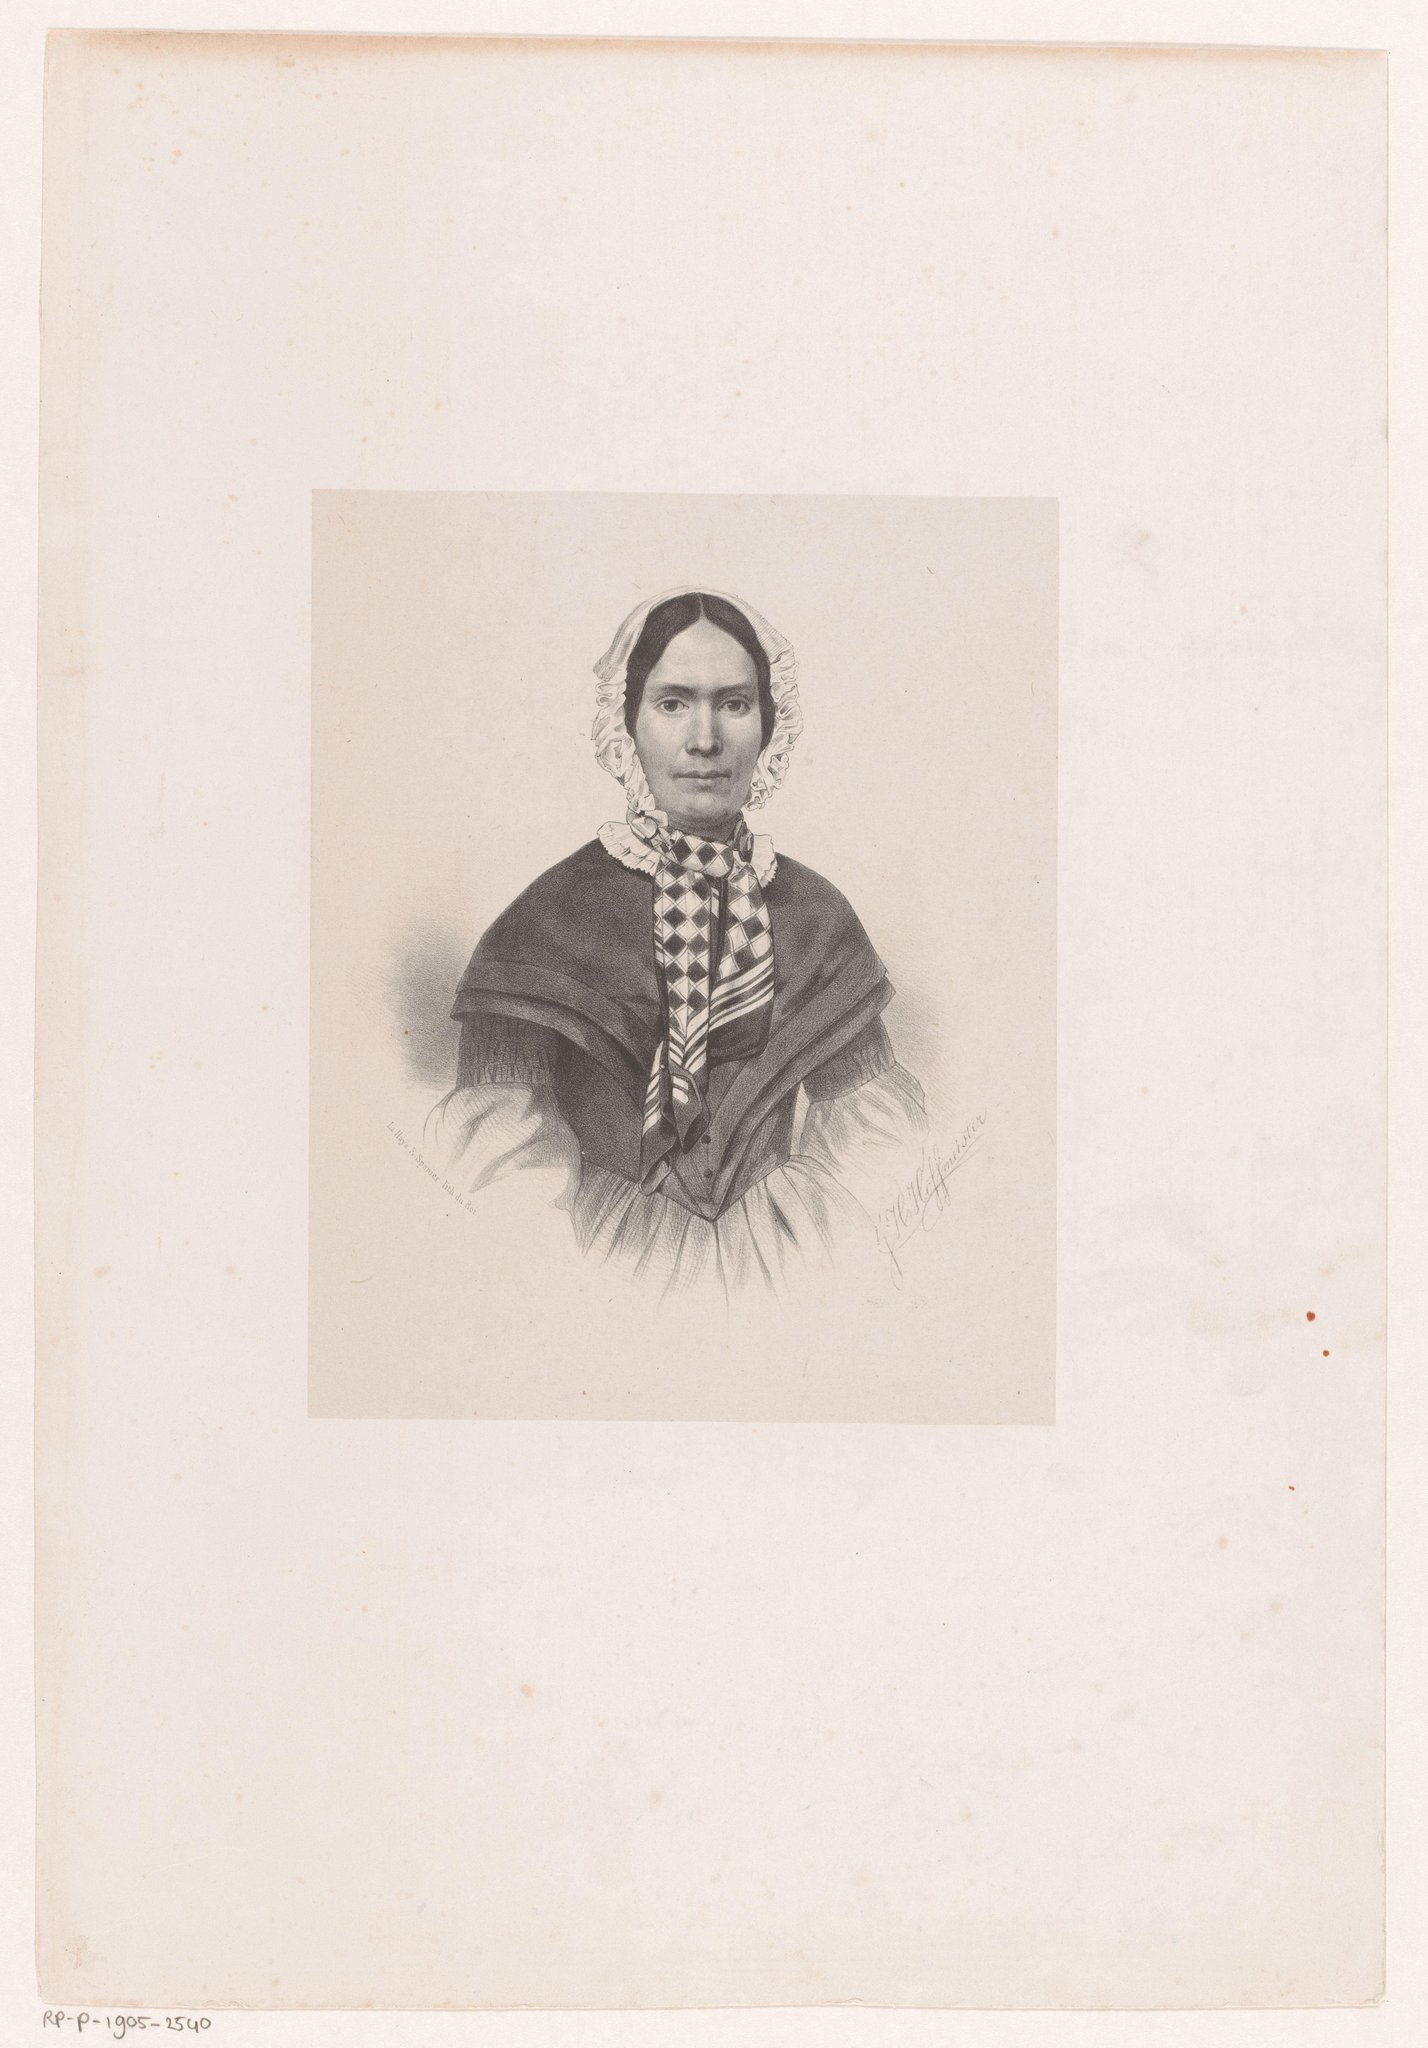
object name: print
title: Portret van een onbekende vrouw met geruite shawl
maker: johan hendrik hoffmeister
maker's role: print maker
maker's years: 1823-1904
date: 1851-1883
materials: paper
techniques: lithograph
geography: netherlands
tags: historical persons - bb - woman (+ (full) bust portrait), neck-gear ~ clothing (shawl) (+ women's clothes)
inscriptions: collector's mark: Lugt 2228